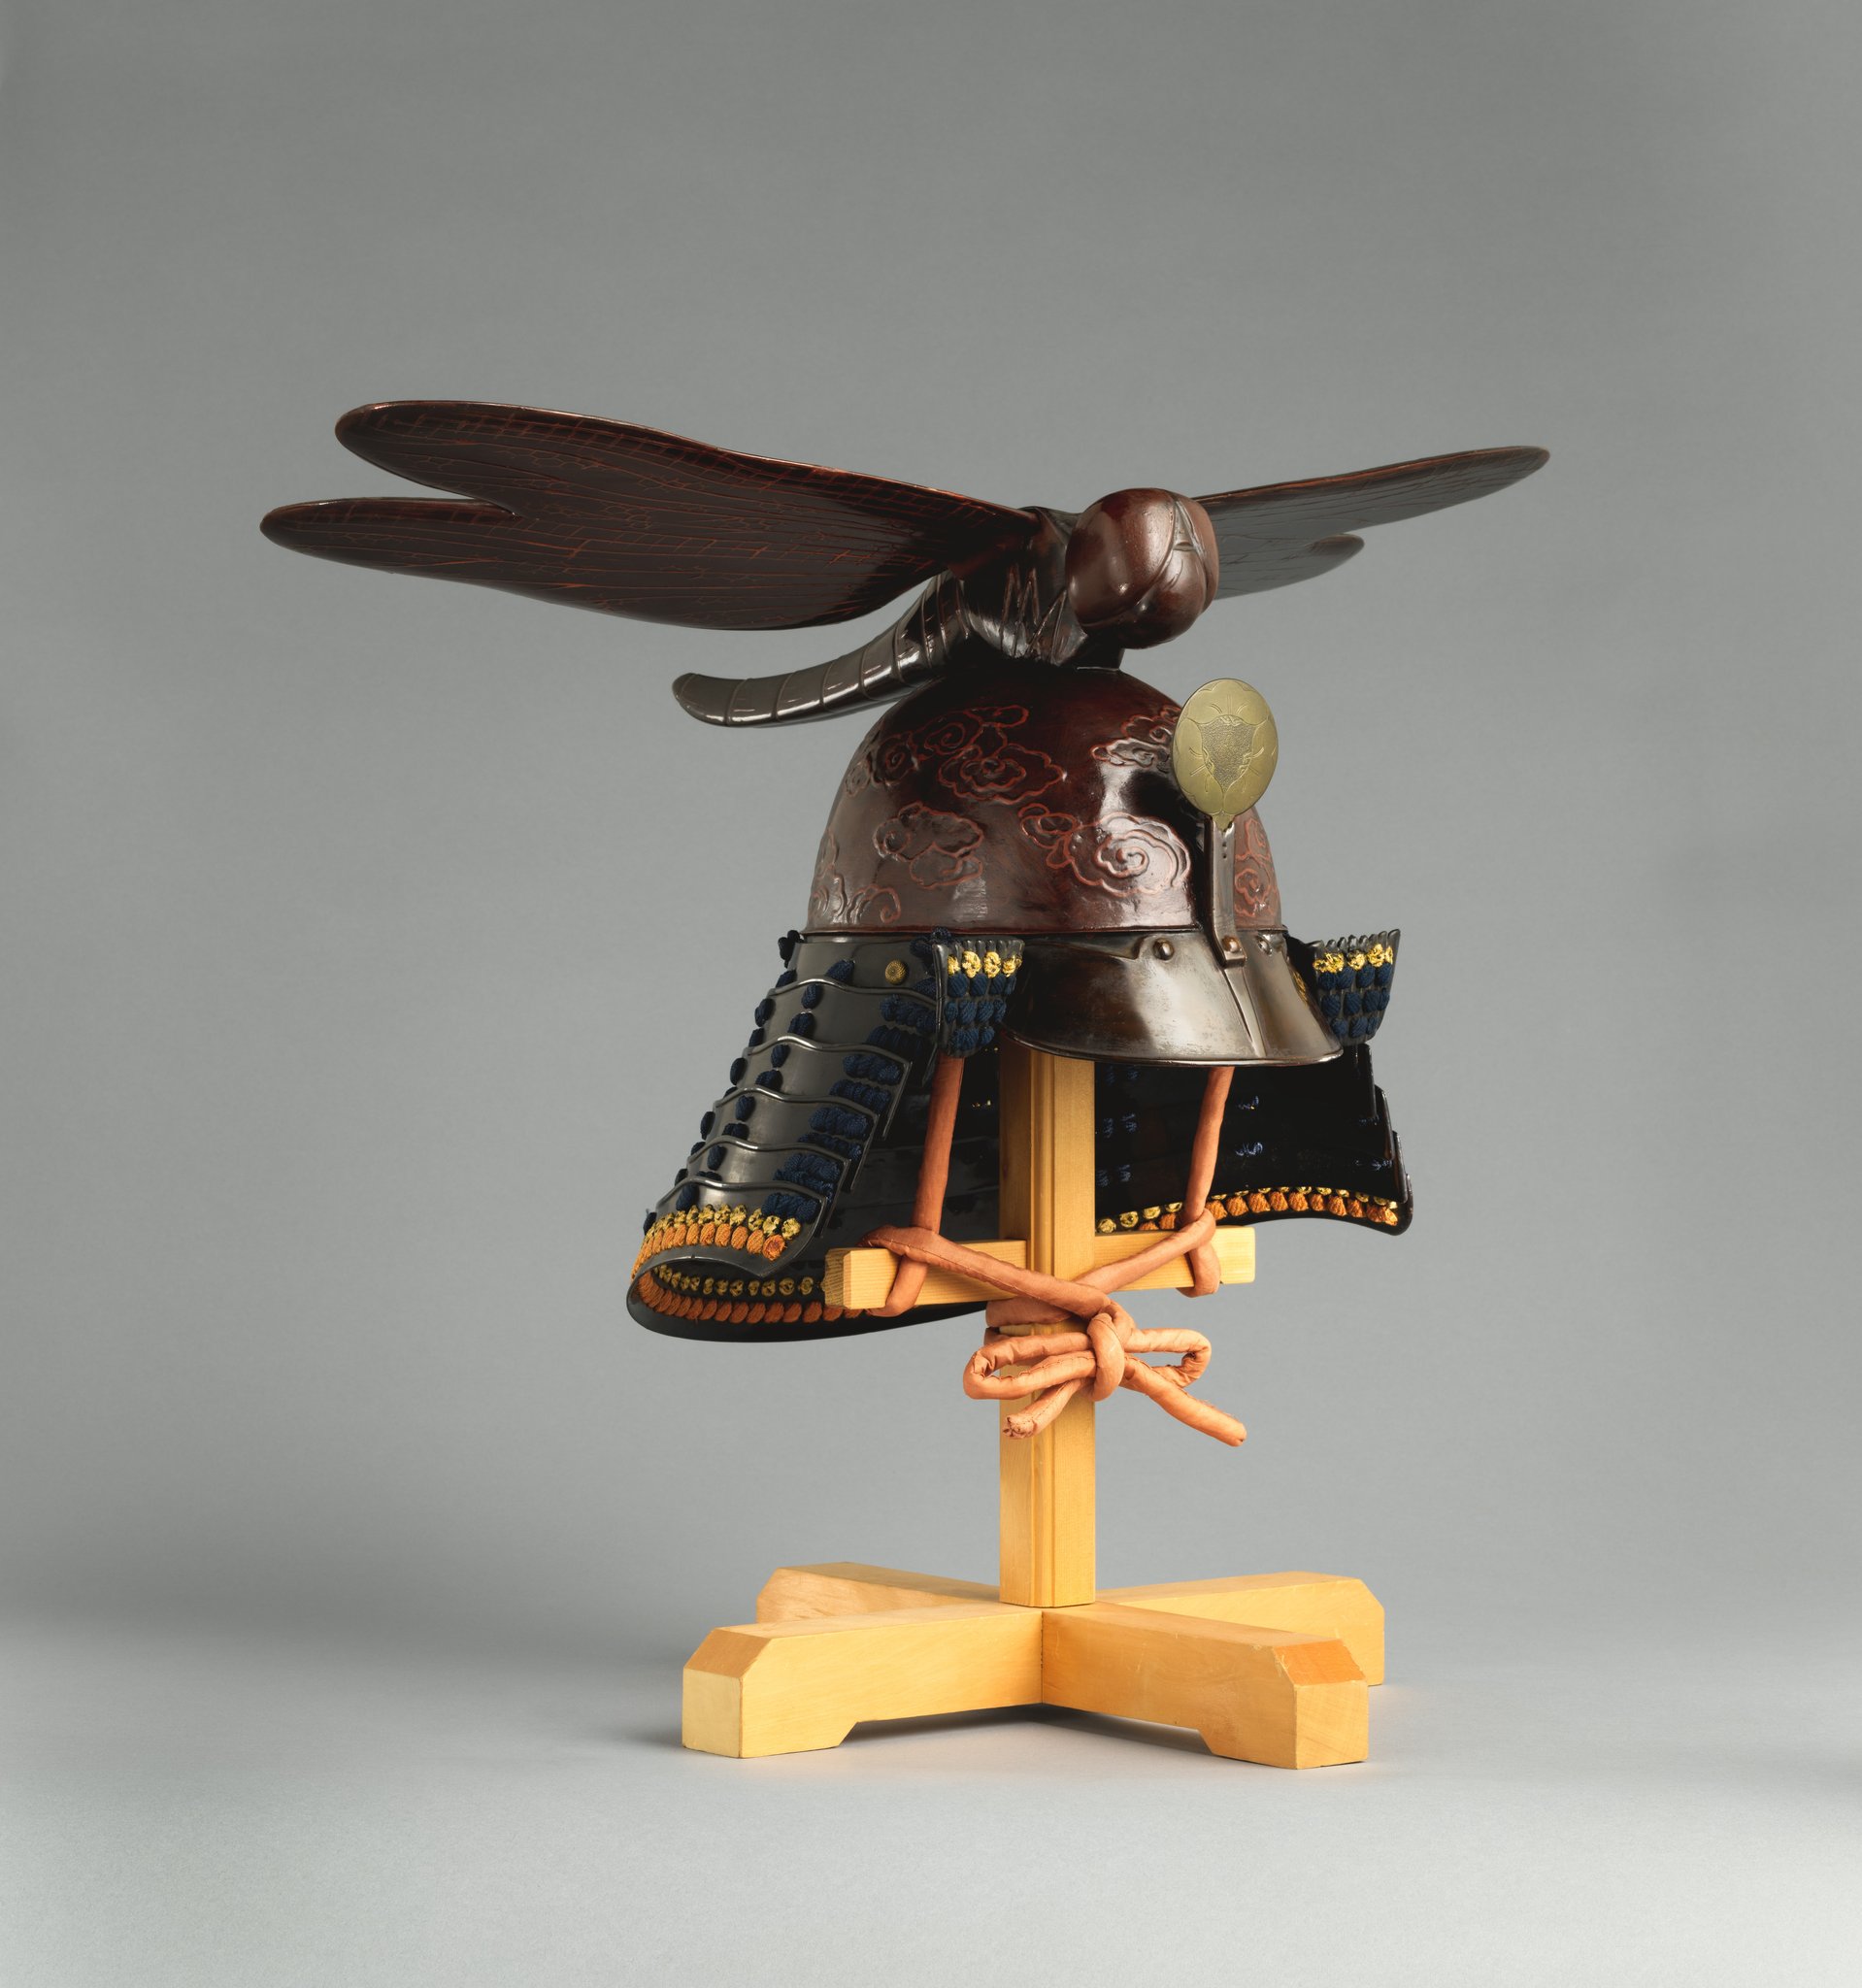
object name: helmet i kawari kabuto i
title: Helmet (Kawari-kabuto) Surmounted by a Dragonfly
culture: japanese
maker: hiromichi miura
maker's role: restorer/conservator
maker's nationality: japanese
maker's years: 1938-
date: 1701-1800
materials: copper, gold, hemp, iron, lacquer, linen, silk, silver, wood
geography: japan